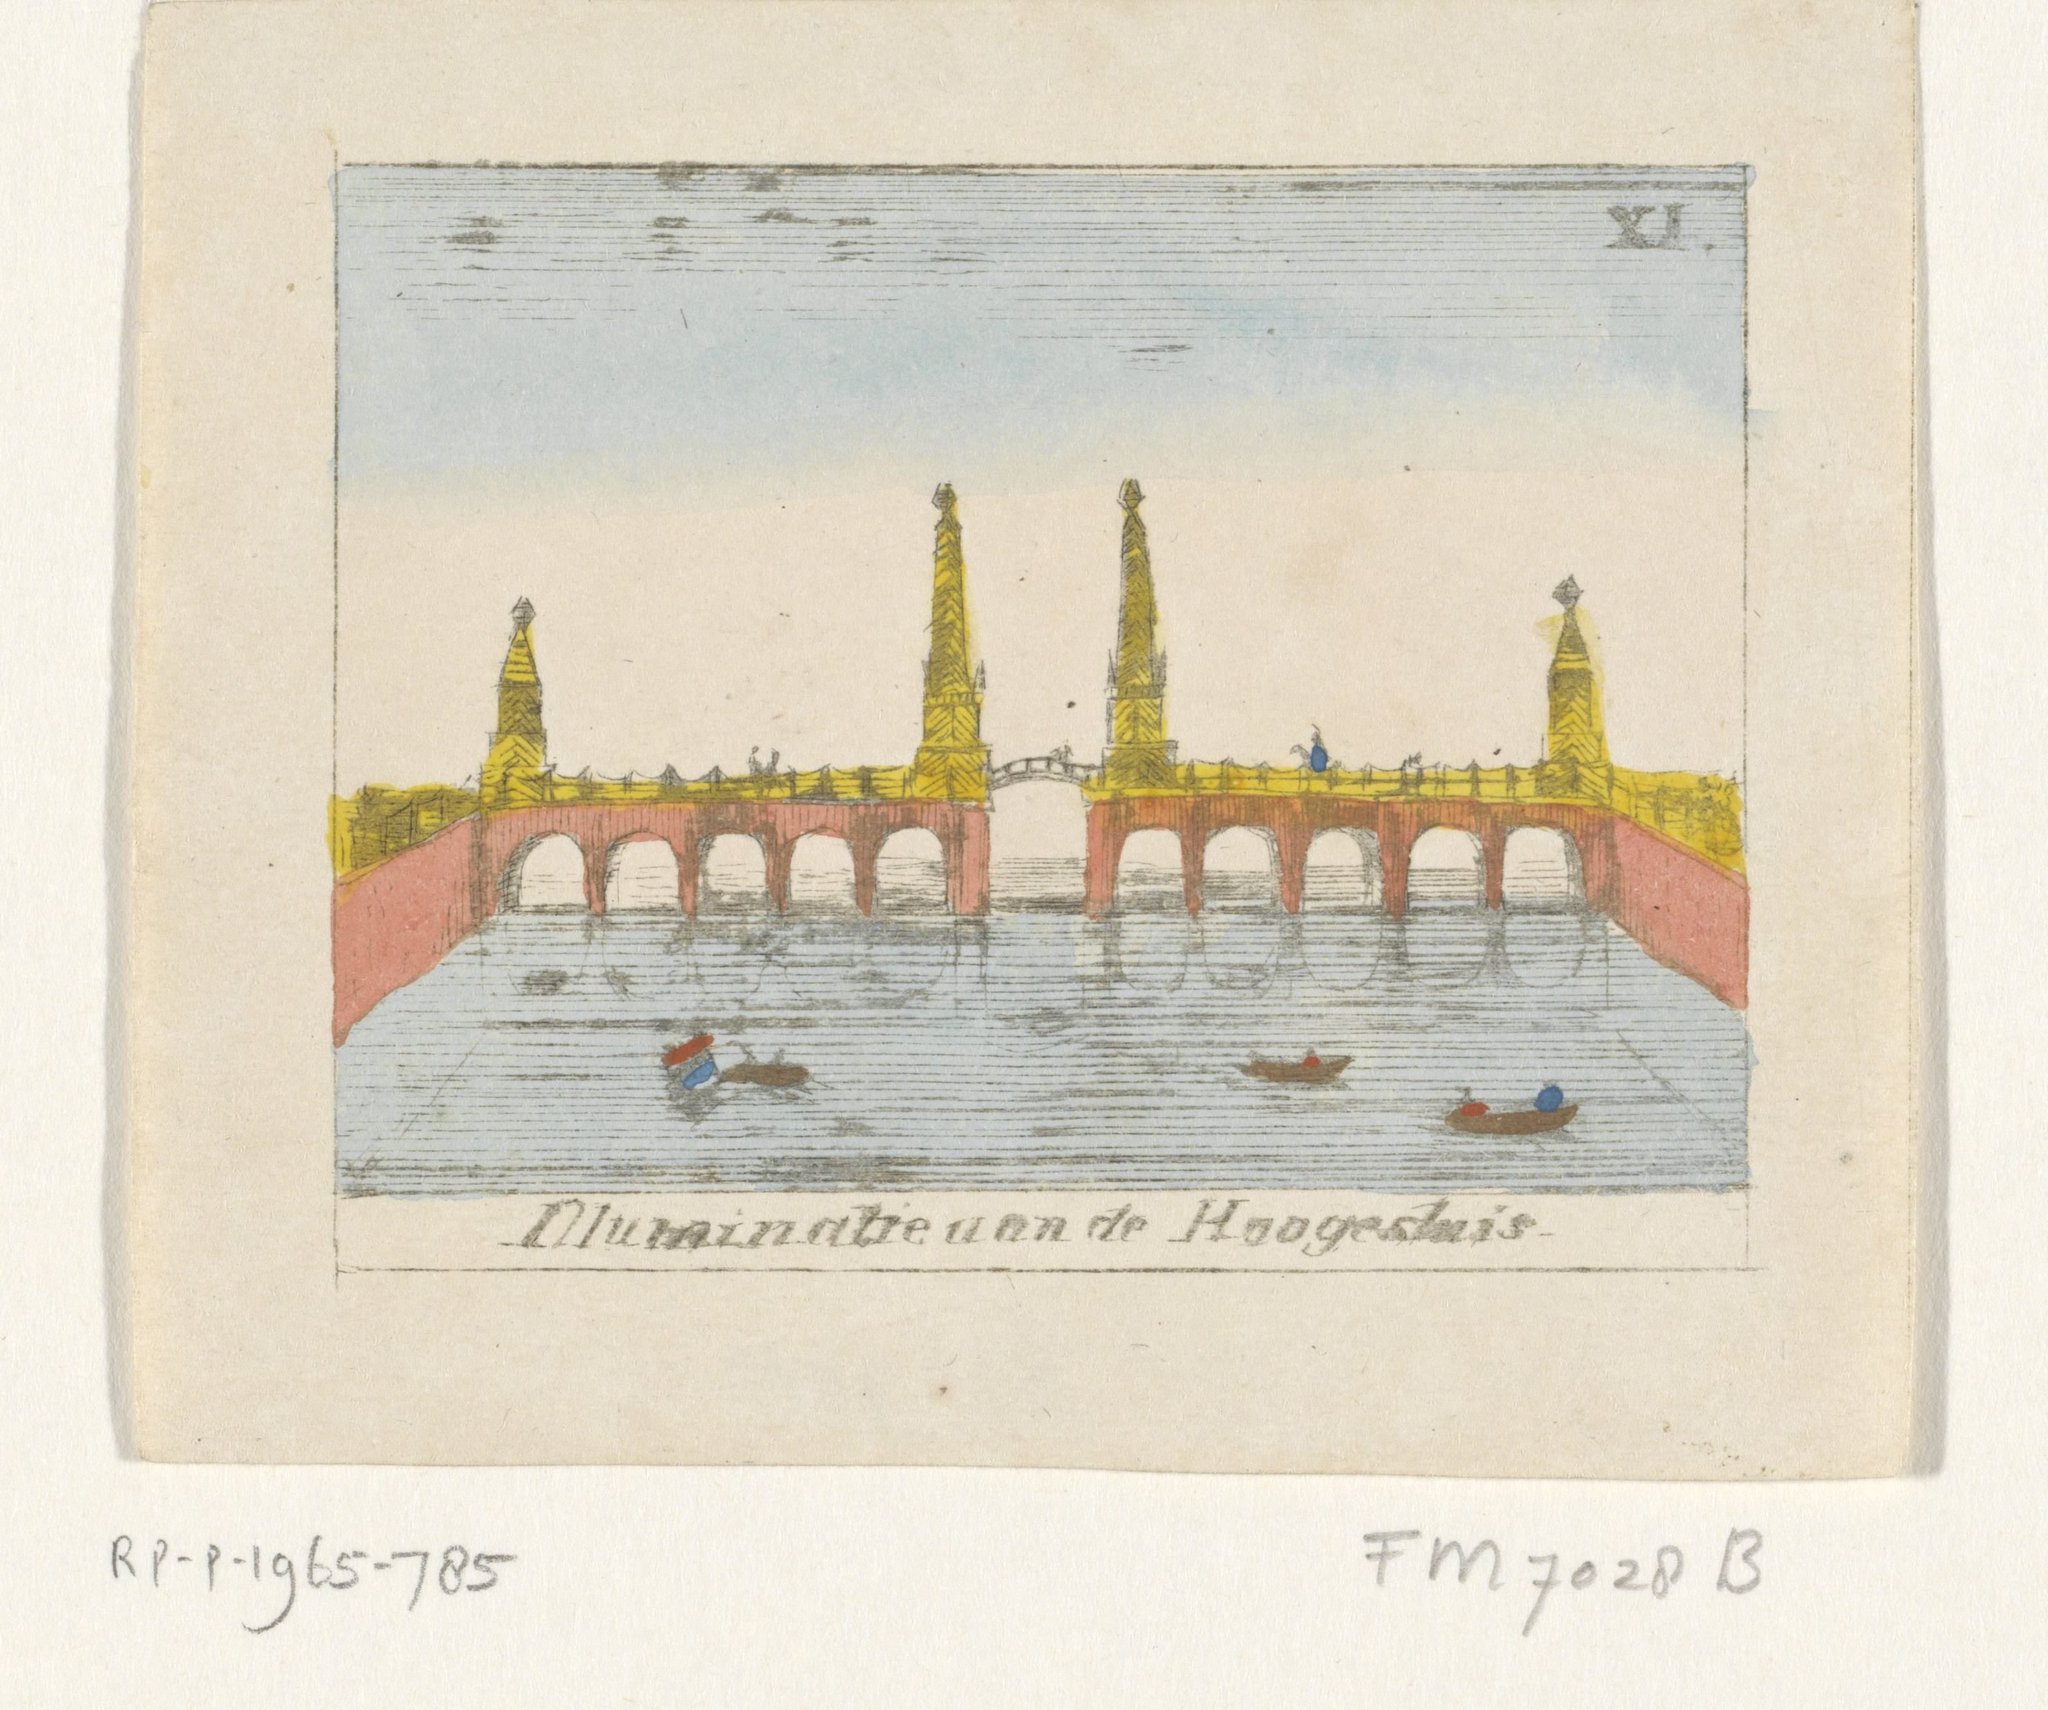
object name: print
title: Herinnerings Geschenkje aan 1840, voor de Nederlandsche Jeugd, ter gedachtenis aan de Plegtige Inhuldiging van Z.M. Koning Willem II. Met XII plaatjes waarop het merkwaardigste is voorgesteld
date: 1840-1841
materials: paper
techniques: hand coloring, lithograph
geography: amsterdam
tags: william ii of the netherlands, triumphal entry and public reception, pageant, 'entrée solennelle', 'joyeuse entrée' (+ illumination, fire-works ~ festive activities), other forms of installation, amsterdam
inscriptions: collector's mark: Lugt 2228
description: Illuminatie op de Hogesluis. Onderdeel van mapje met een serie van twaalf prentjes van de intocht van Willem II, de erepoorten opgericht in de stad en de inhuldiging op 28 november 1840 in de Nieuwe Kerk te Amsterdam.